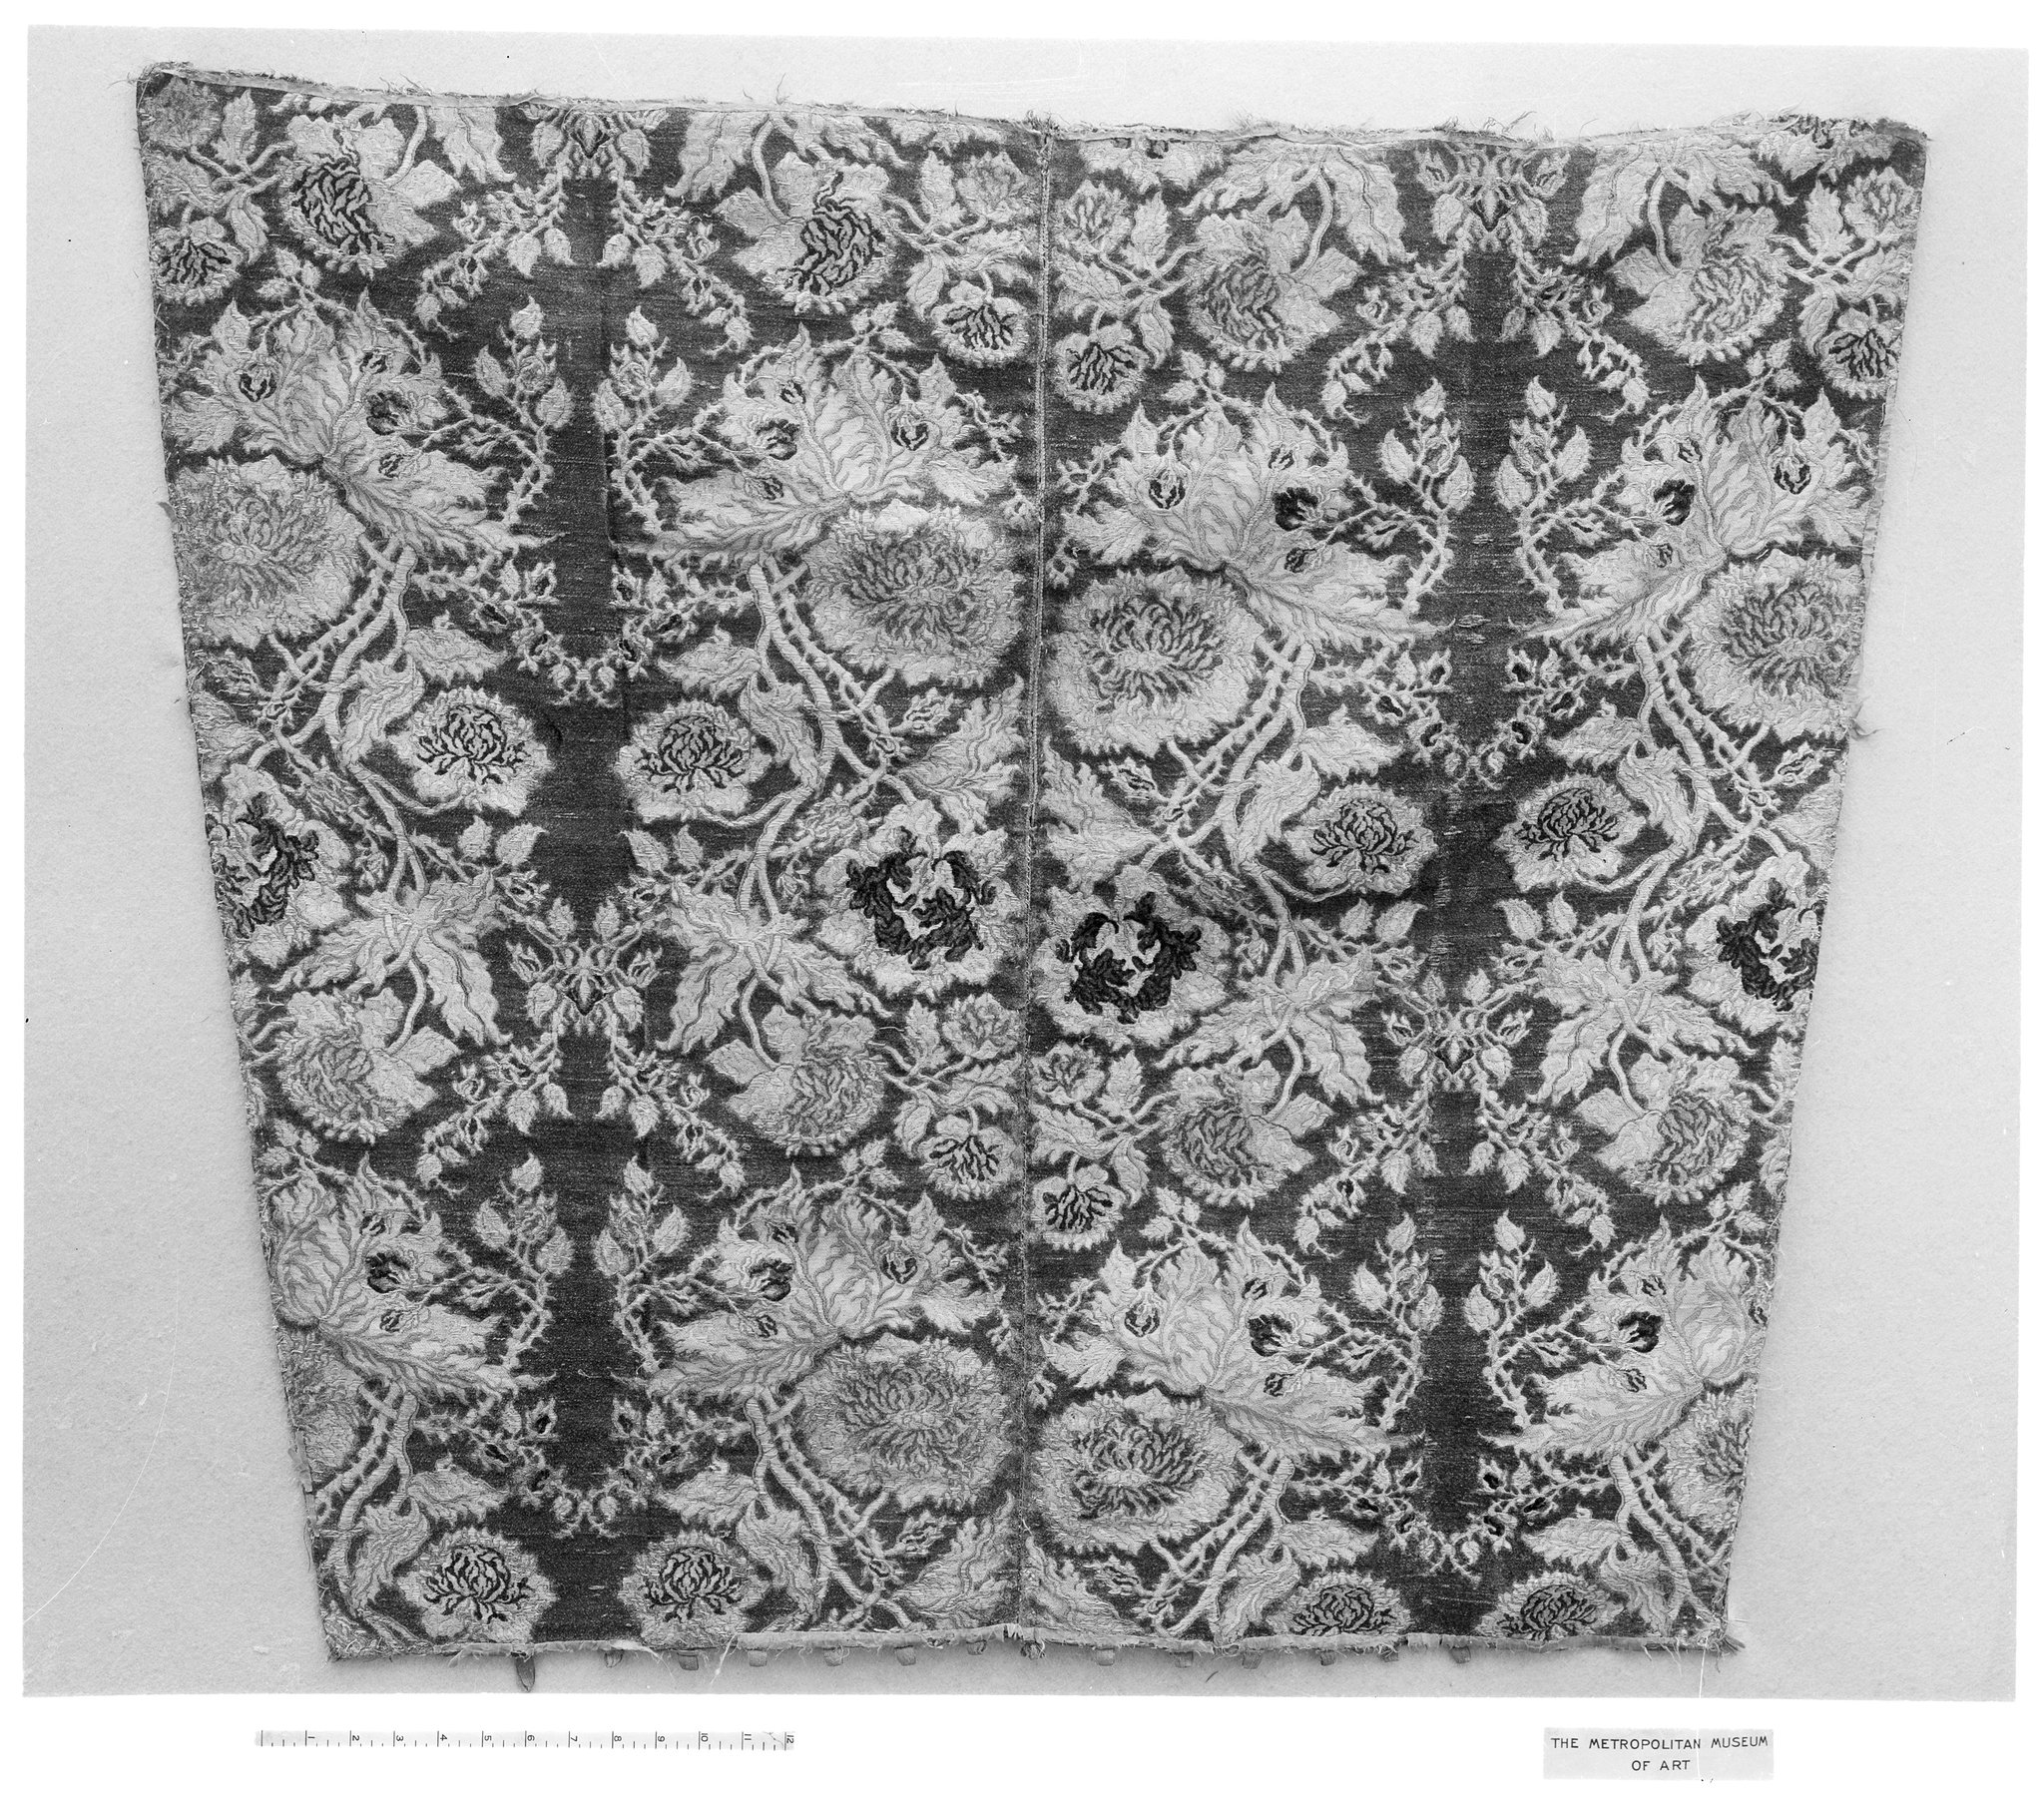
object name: piece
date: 1734-1766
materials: metal thread, silk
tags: flowers,leaves